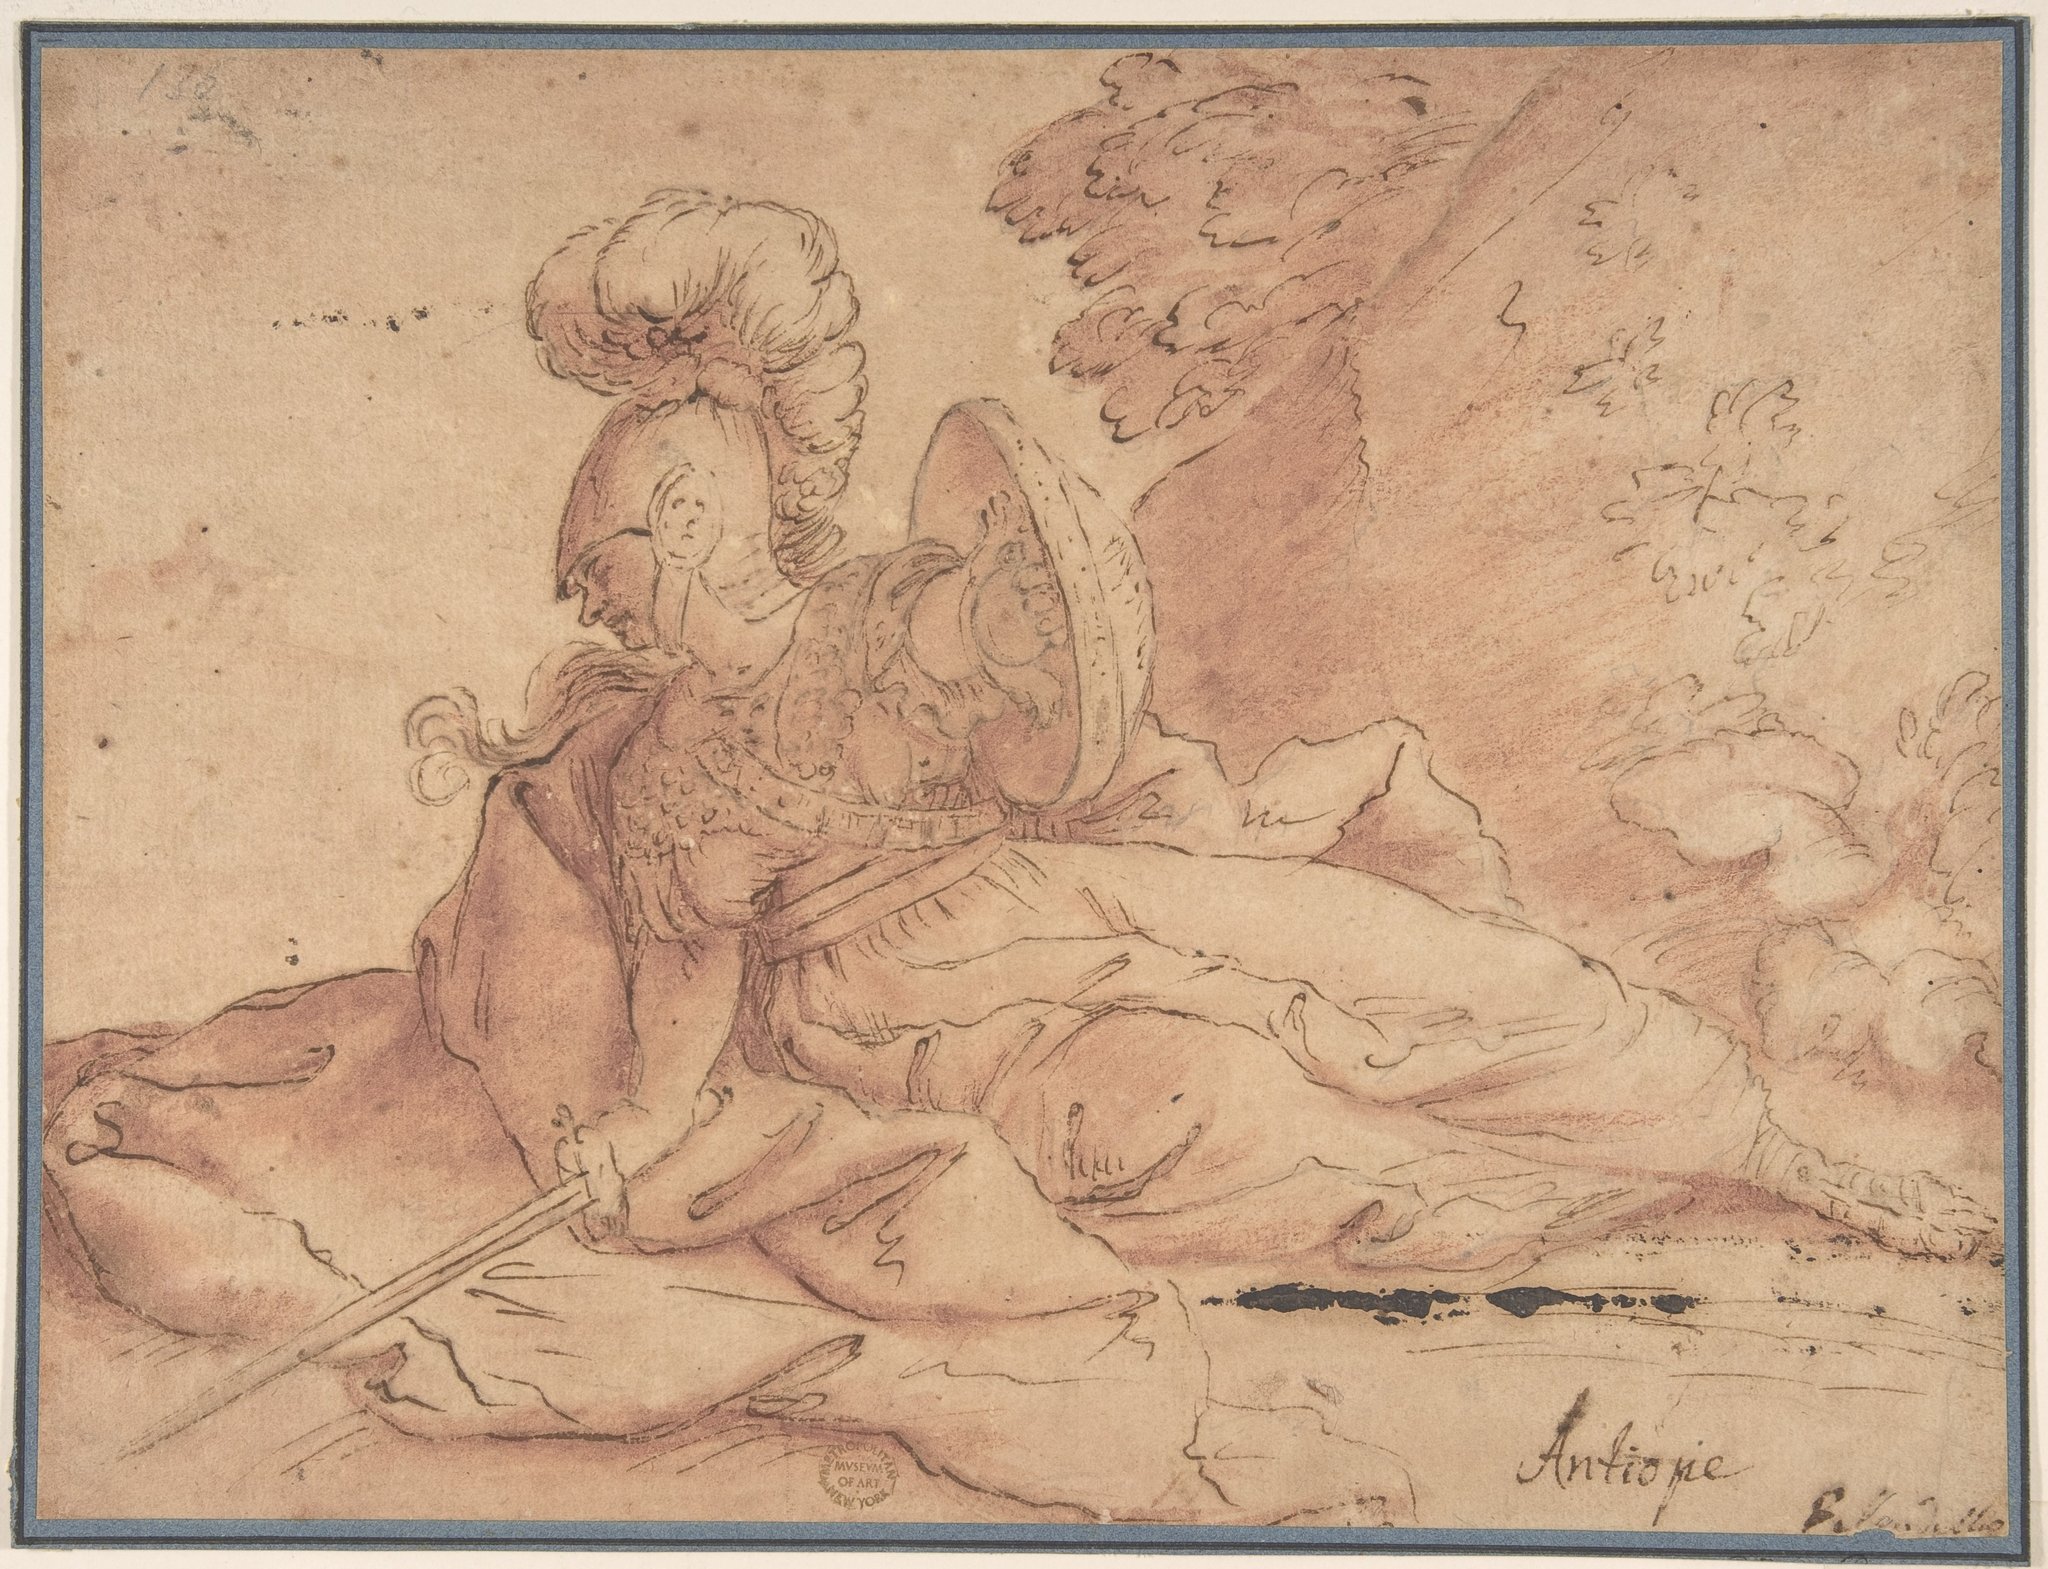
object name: drawing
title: Antiope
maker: anonymous, italian, 17th century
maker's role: artist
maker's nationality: italian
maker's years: 1600-1700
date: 1601-1700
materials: chalk, ink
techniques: pen, wash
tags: soldiers